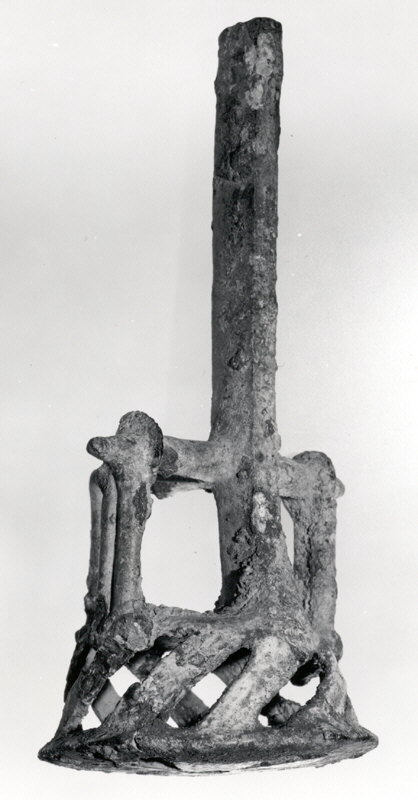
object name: openwork object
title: Openwork cage object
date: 900-801 BCE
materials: bronze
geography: northwestern iran